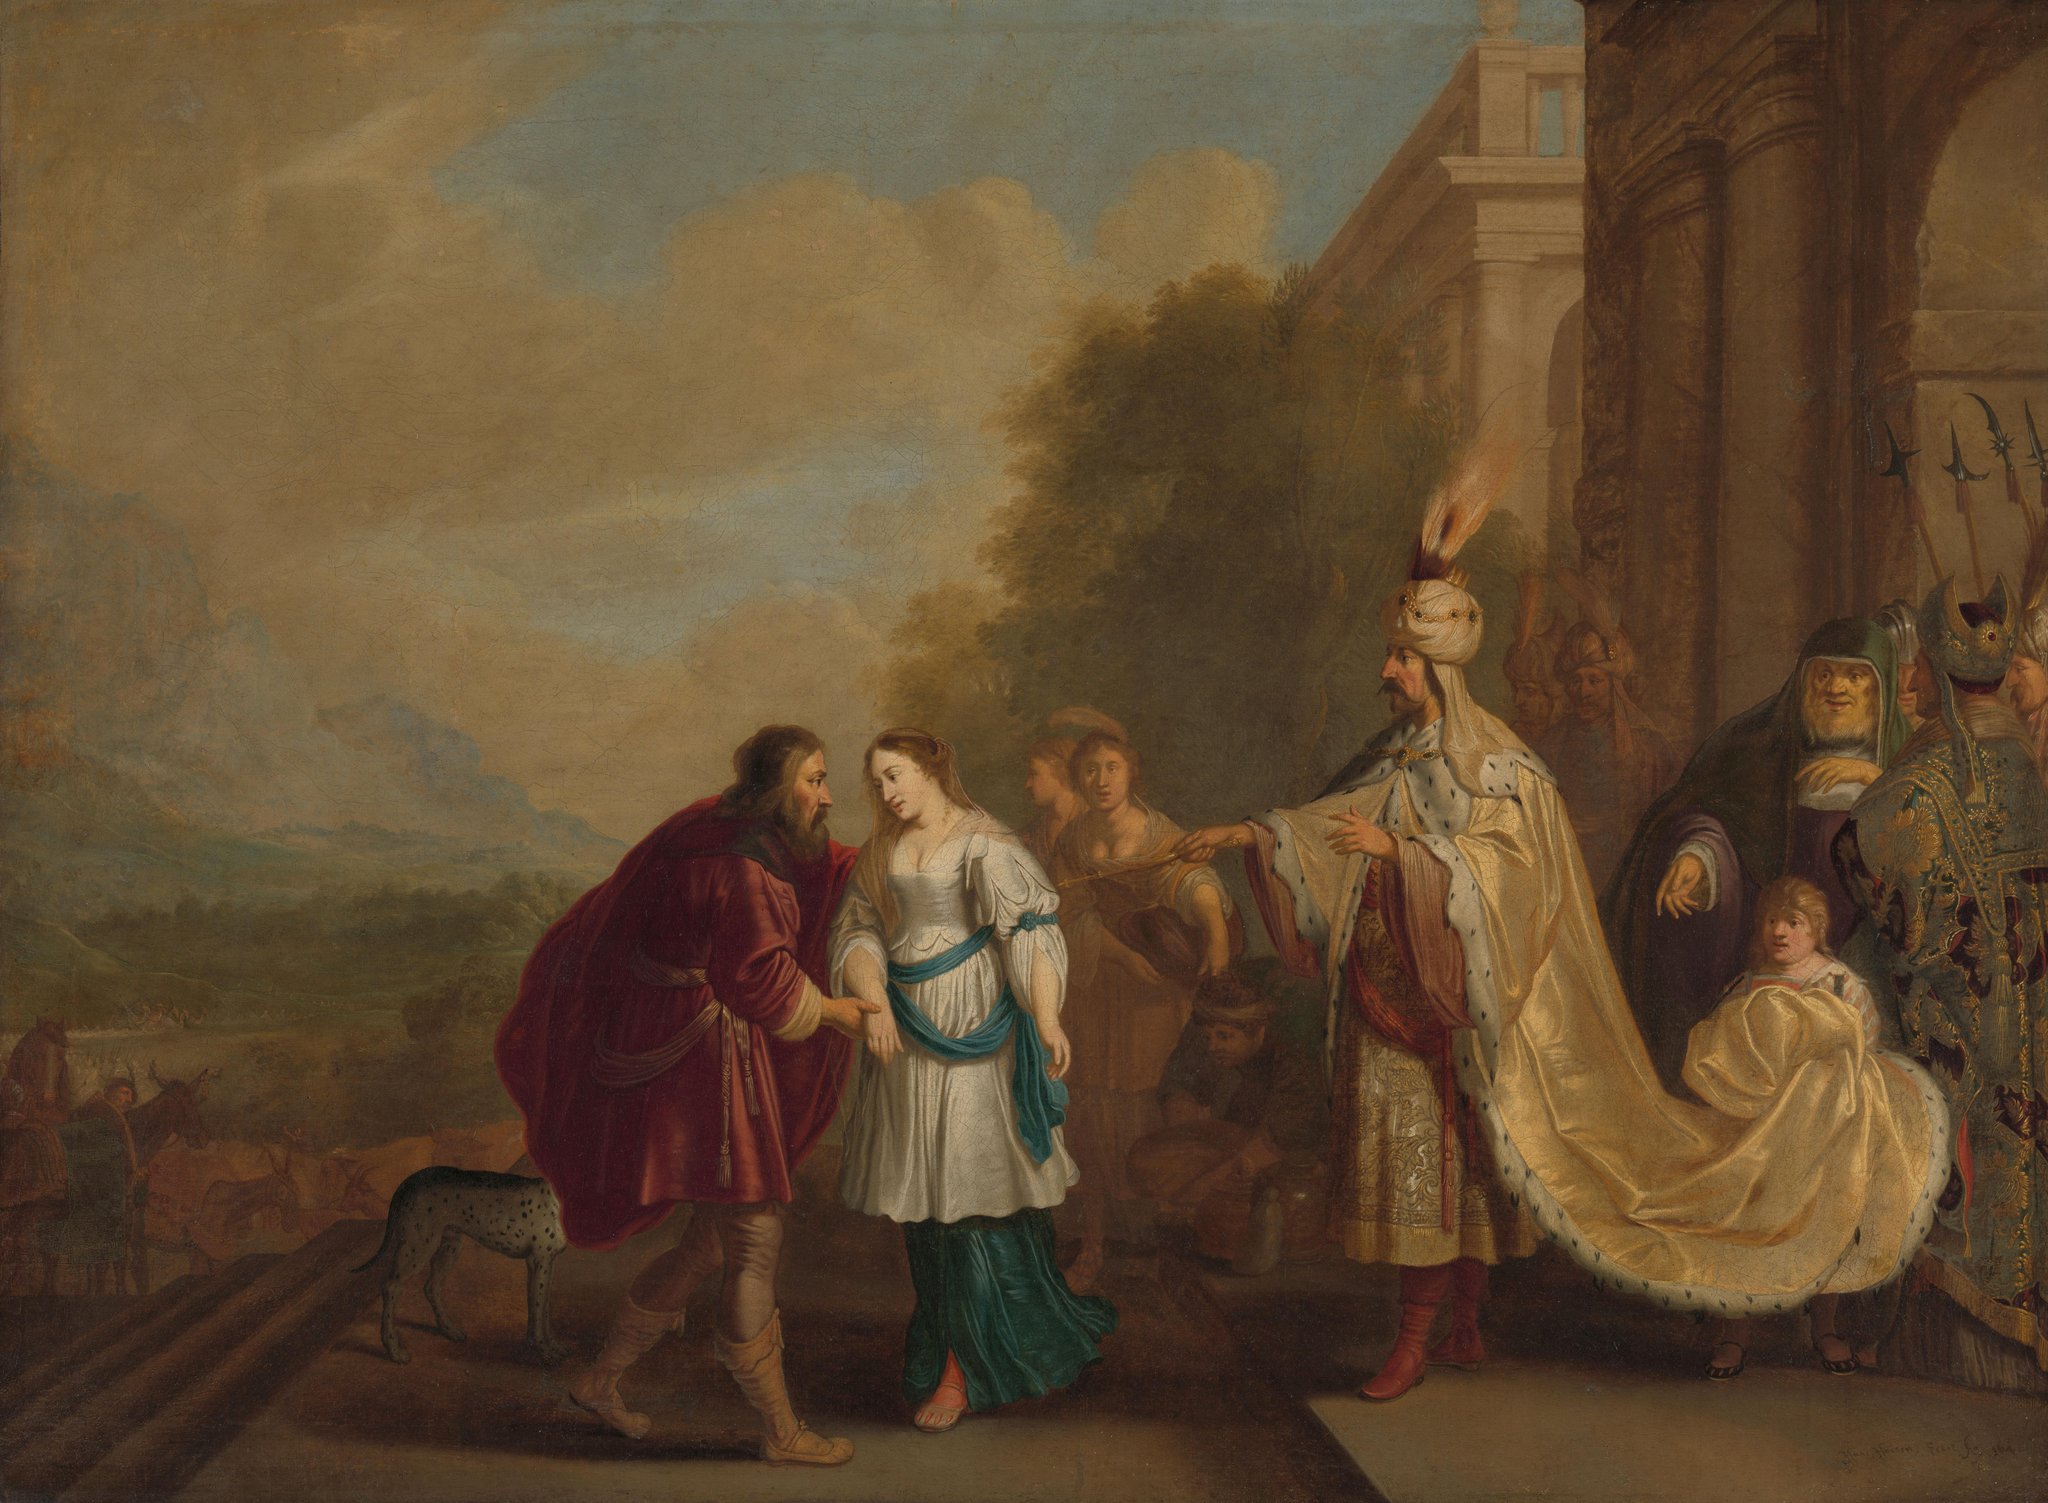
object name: painting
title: Pharaoh Gives Sarah Back to Abraham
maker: isaac isaacsz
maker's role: painter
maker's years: 1598-1649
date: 1640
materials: canvas, oil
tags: abraham is summoned before pharaoh, and is ordered to leave egypt with sarah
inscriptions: signature and date, bottom right: ‘Isaac Isacsen. Fecit Aº 1640’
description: Farao geeft Sara aan Abraham terug. De handeling vindt plaats bovenaan de trappen voor het paleis van de koning. De koning staat rechts met een tulband op het hoofd en gekleed in een lange hermelijnen mantel. Achter hem hogepriesters en soldaten. Links Abraham met een hond.